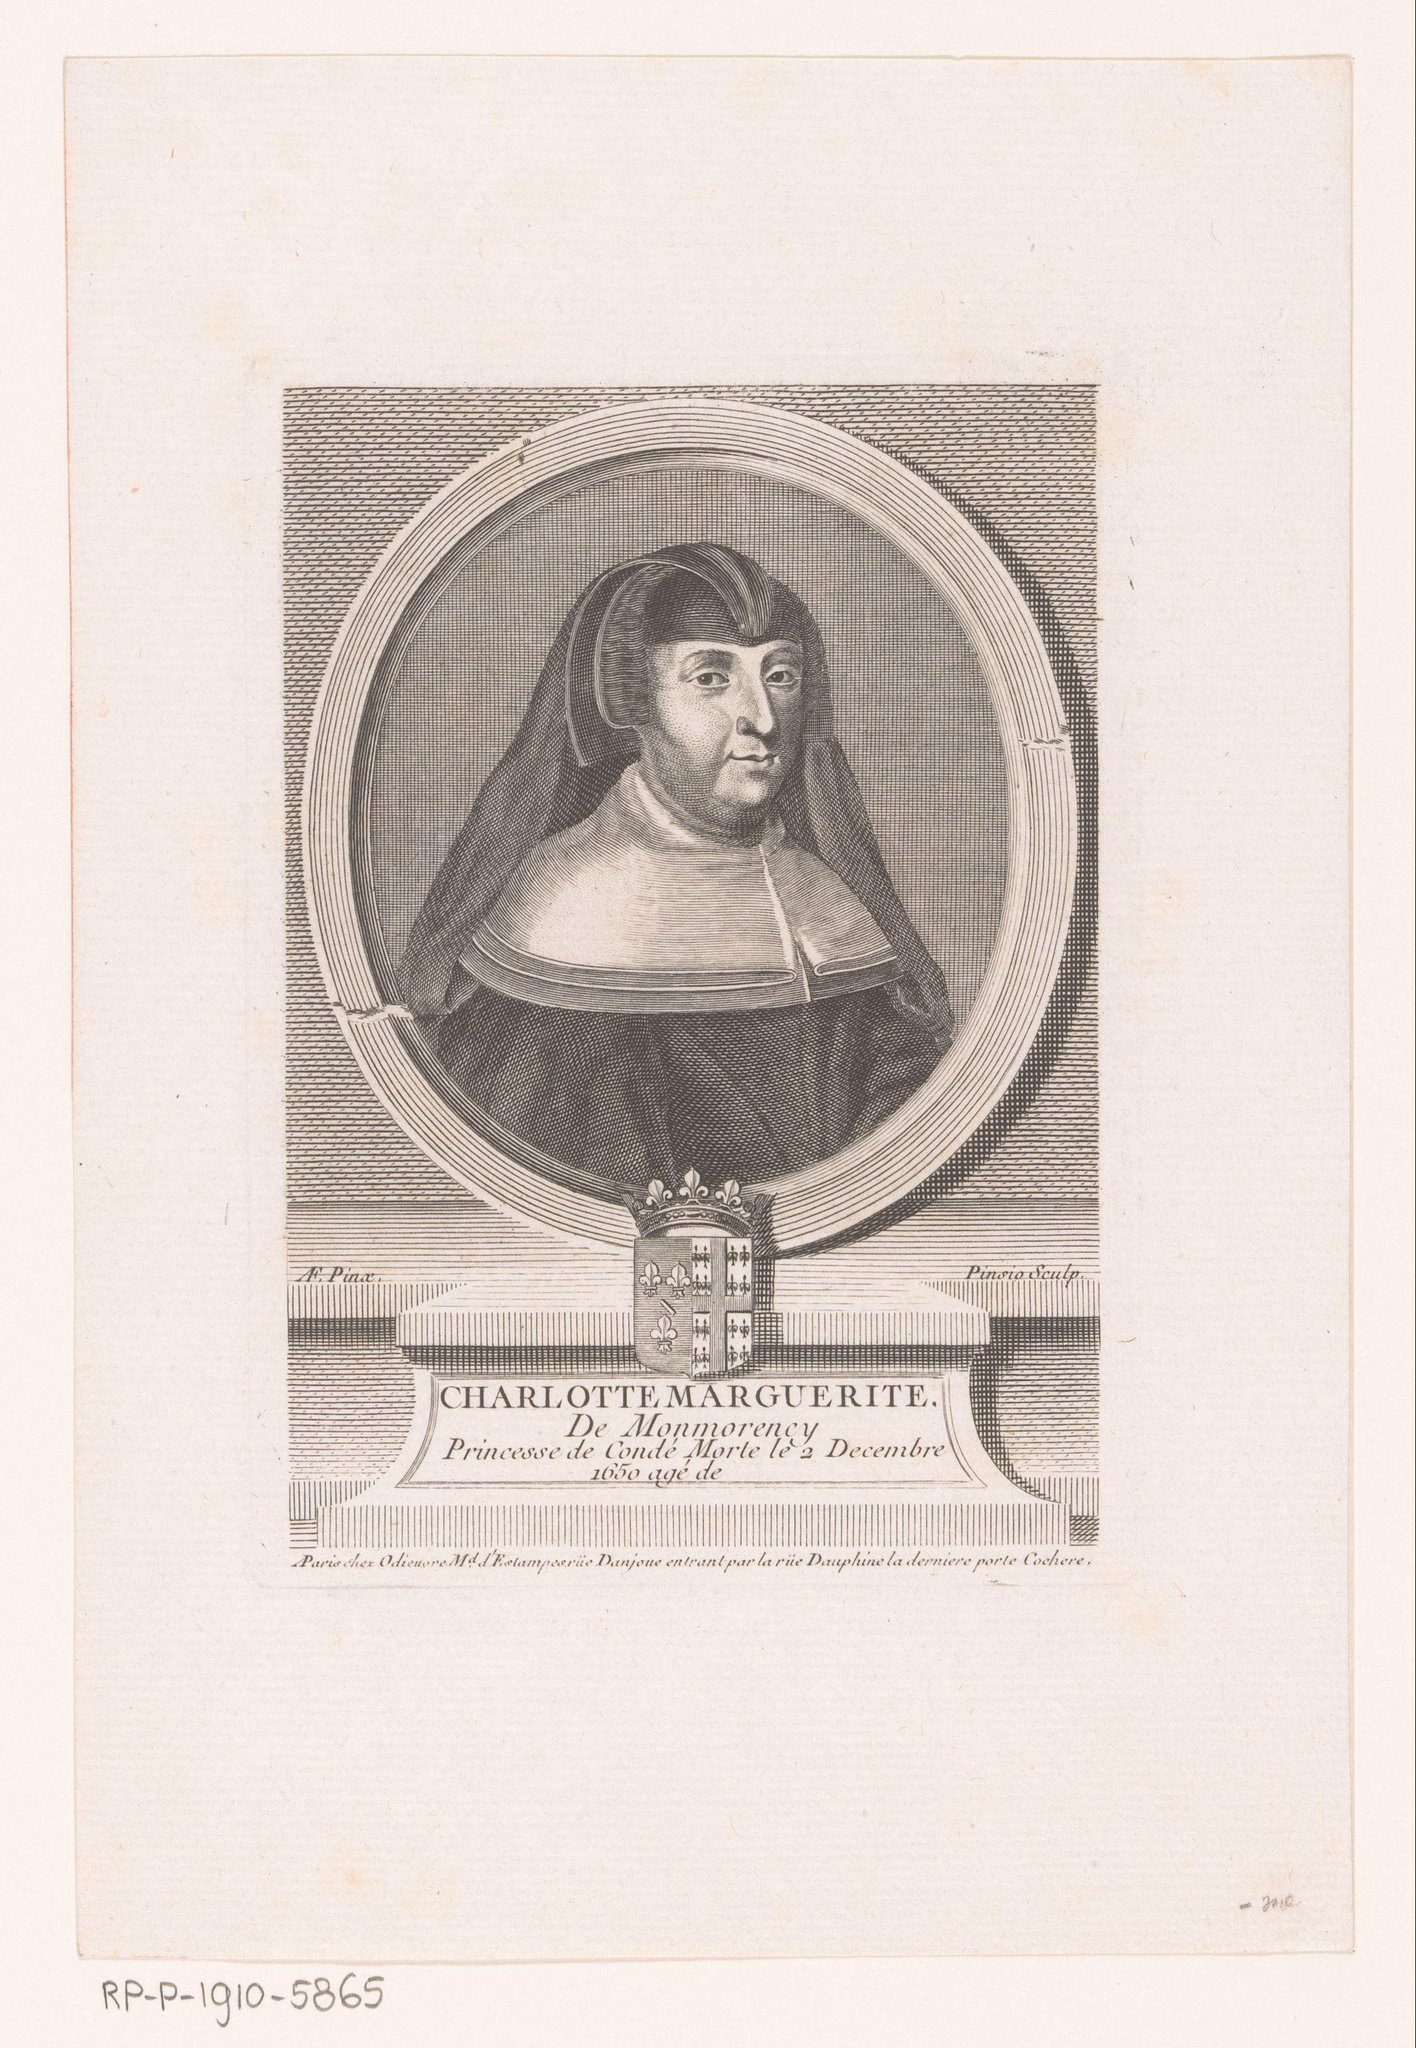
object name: book illustration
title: Portret van Charlotte Marguerite de Montmorency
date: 1755-1765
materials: paper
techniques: engraving, etching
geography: paris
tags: chantilly, historical persons, dignitary at court - bb - female dignitary: lady-in-waiting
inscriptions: collector's mark: Lugt 2228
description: Prent uit: Dreux du Radier, Jean-François. L'Europe illustré, contenant l'histoire abregée des souverains, des princes, des prélats, des ministres, (...) en Europe: dans le XVe. siècle compris, jusqu'à présent. Parijs: Michel Odieuvre en André-François Le Breton, 1755-1765.